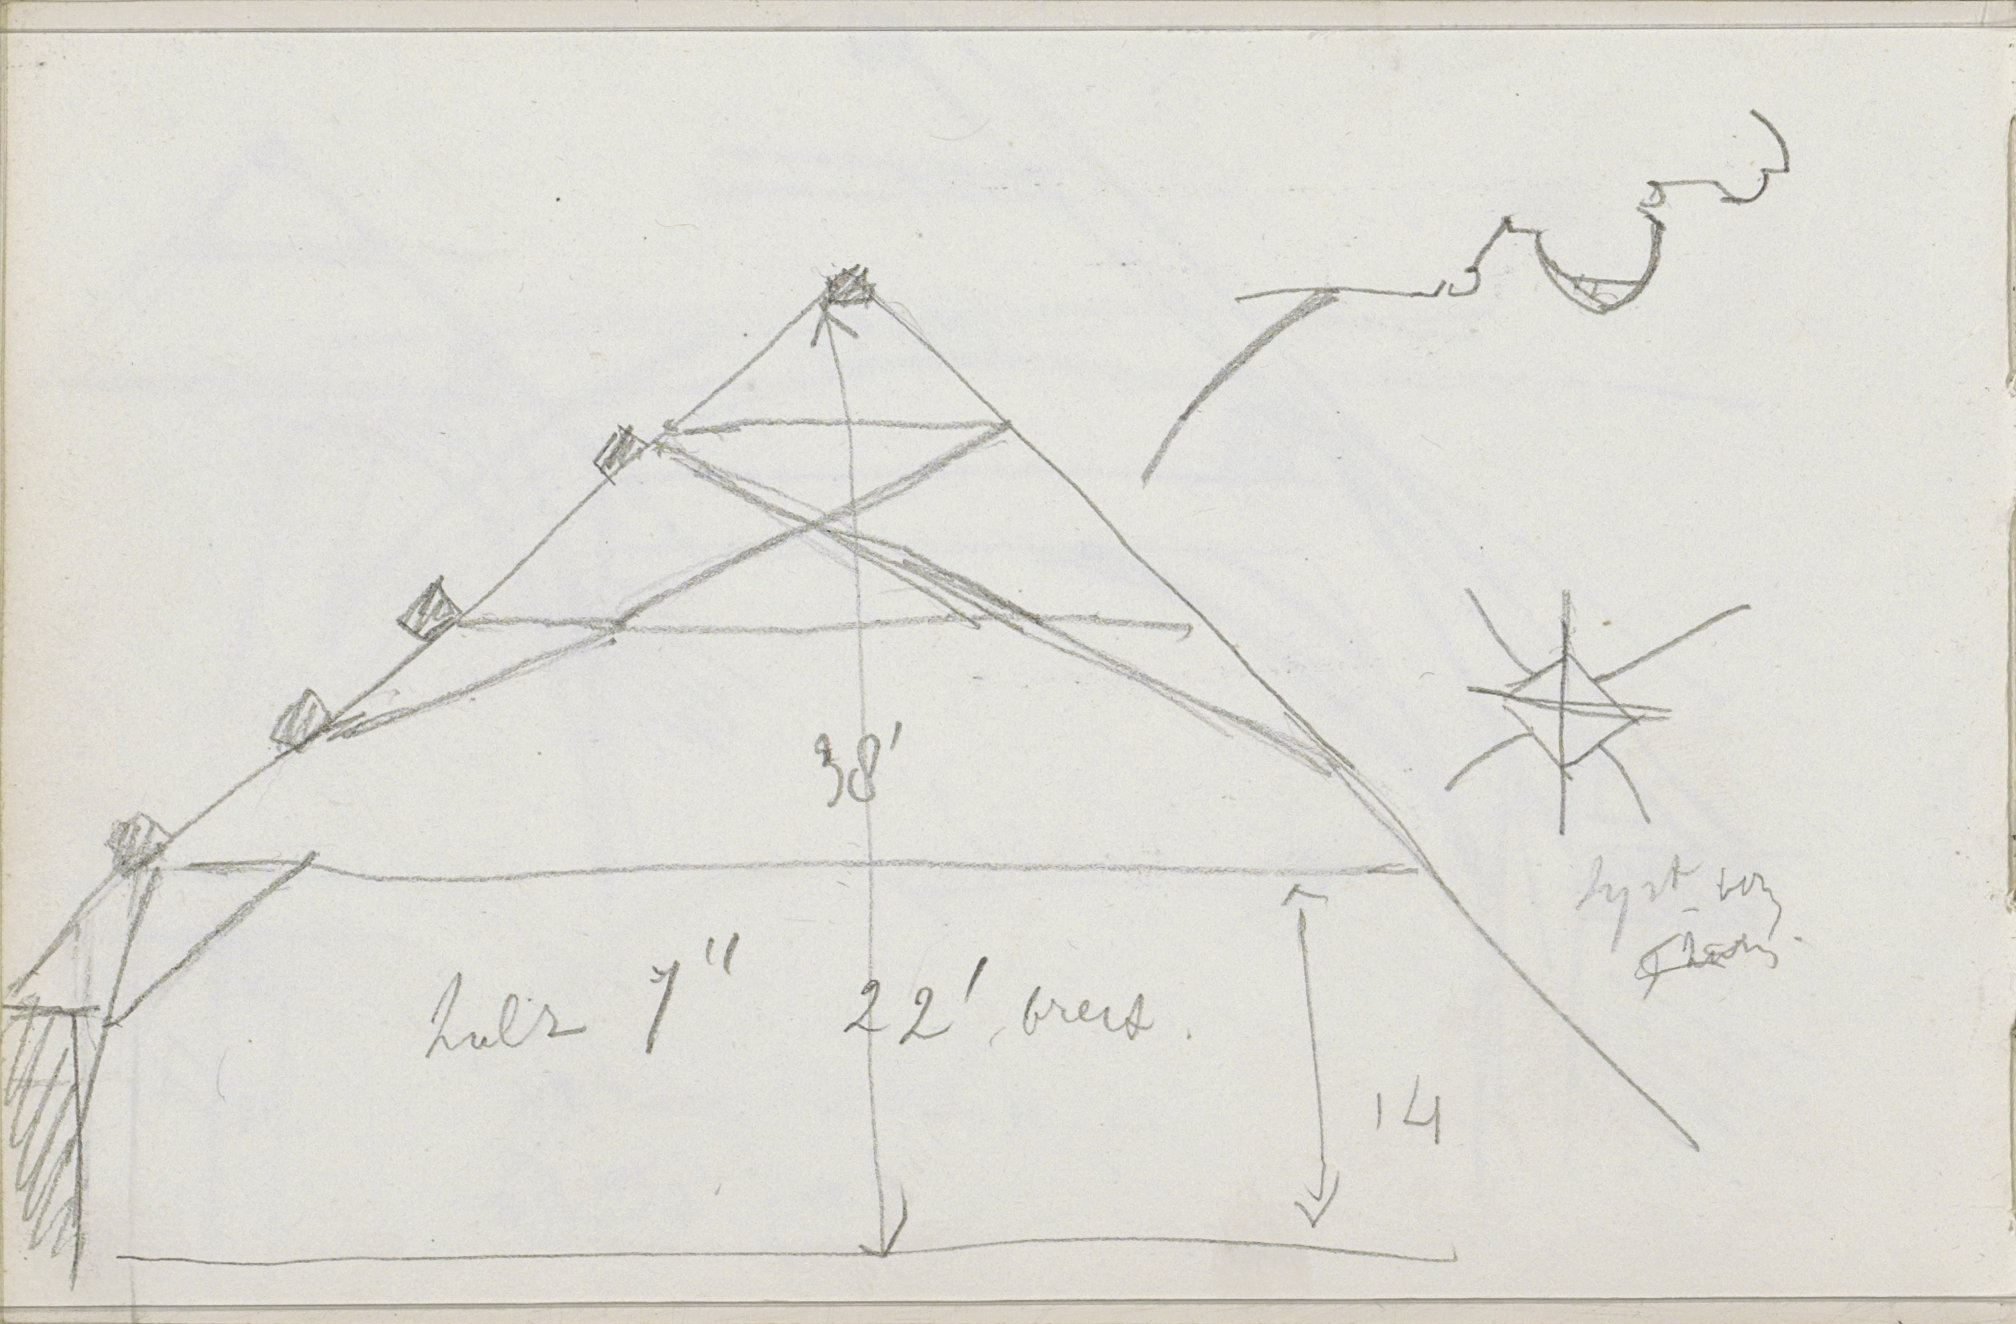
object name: sketchbook leaf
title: Constructie voor een puntdak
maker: isaac gosschalk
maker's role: draughtsman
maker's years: 1838-1907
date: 1860-1861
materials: paper, pencil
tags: roof (of house or building)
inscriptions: annotation: ‘[...]’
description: Blad 23 verso uit een schetsboek met 29 bladen.